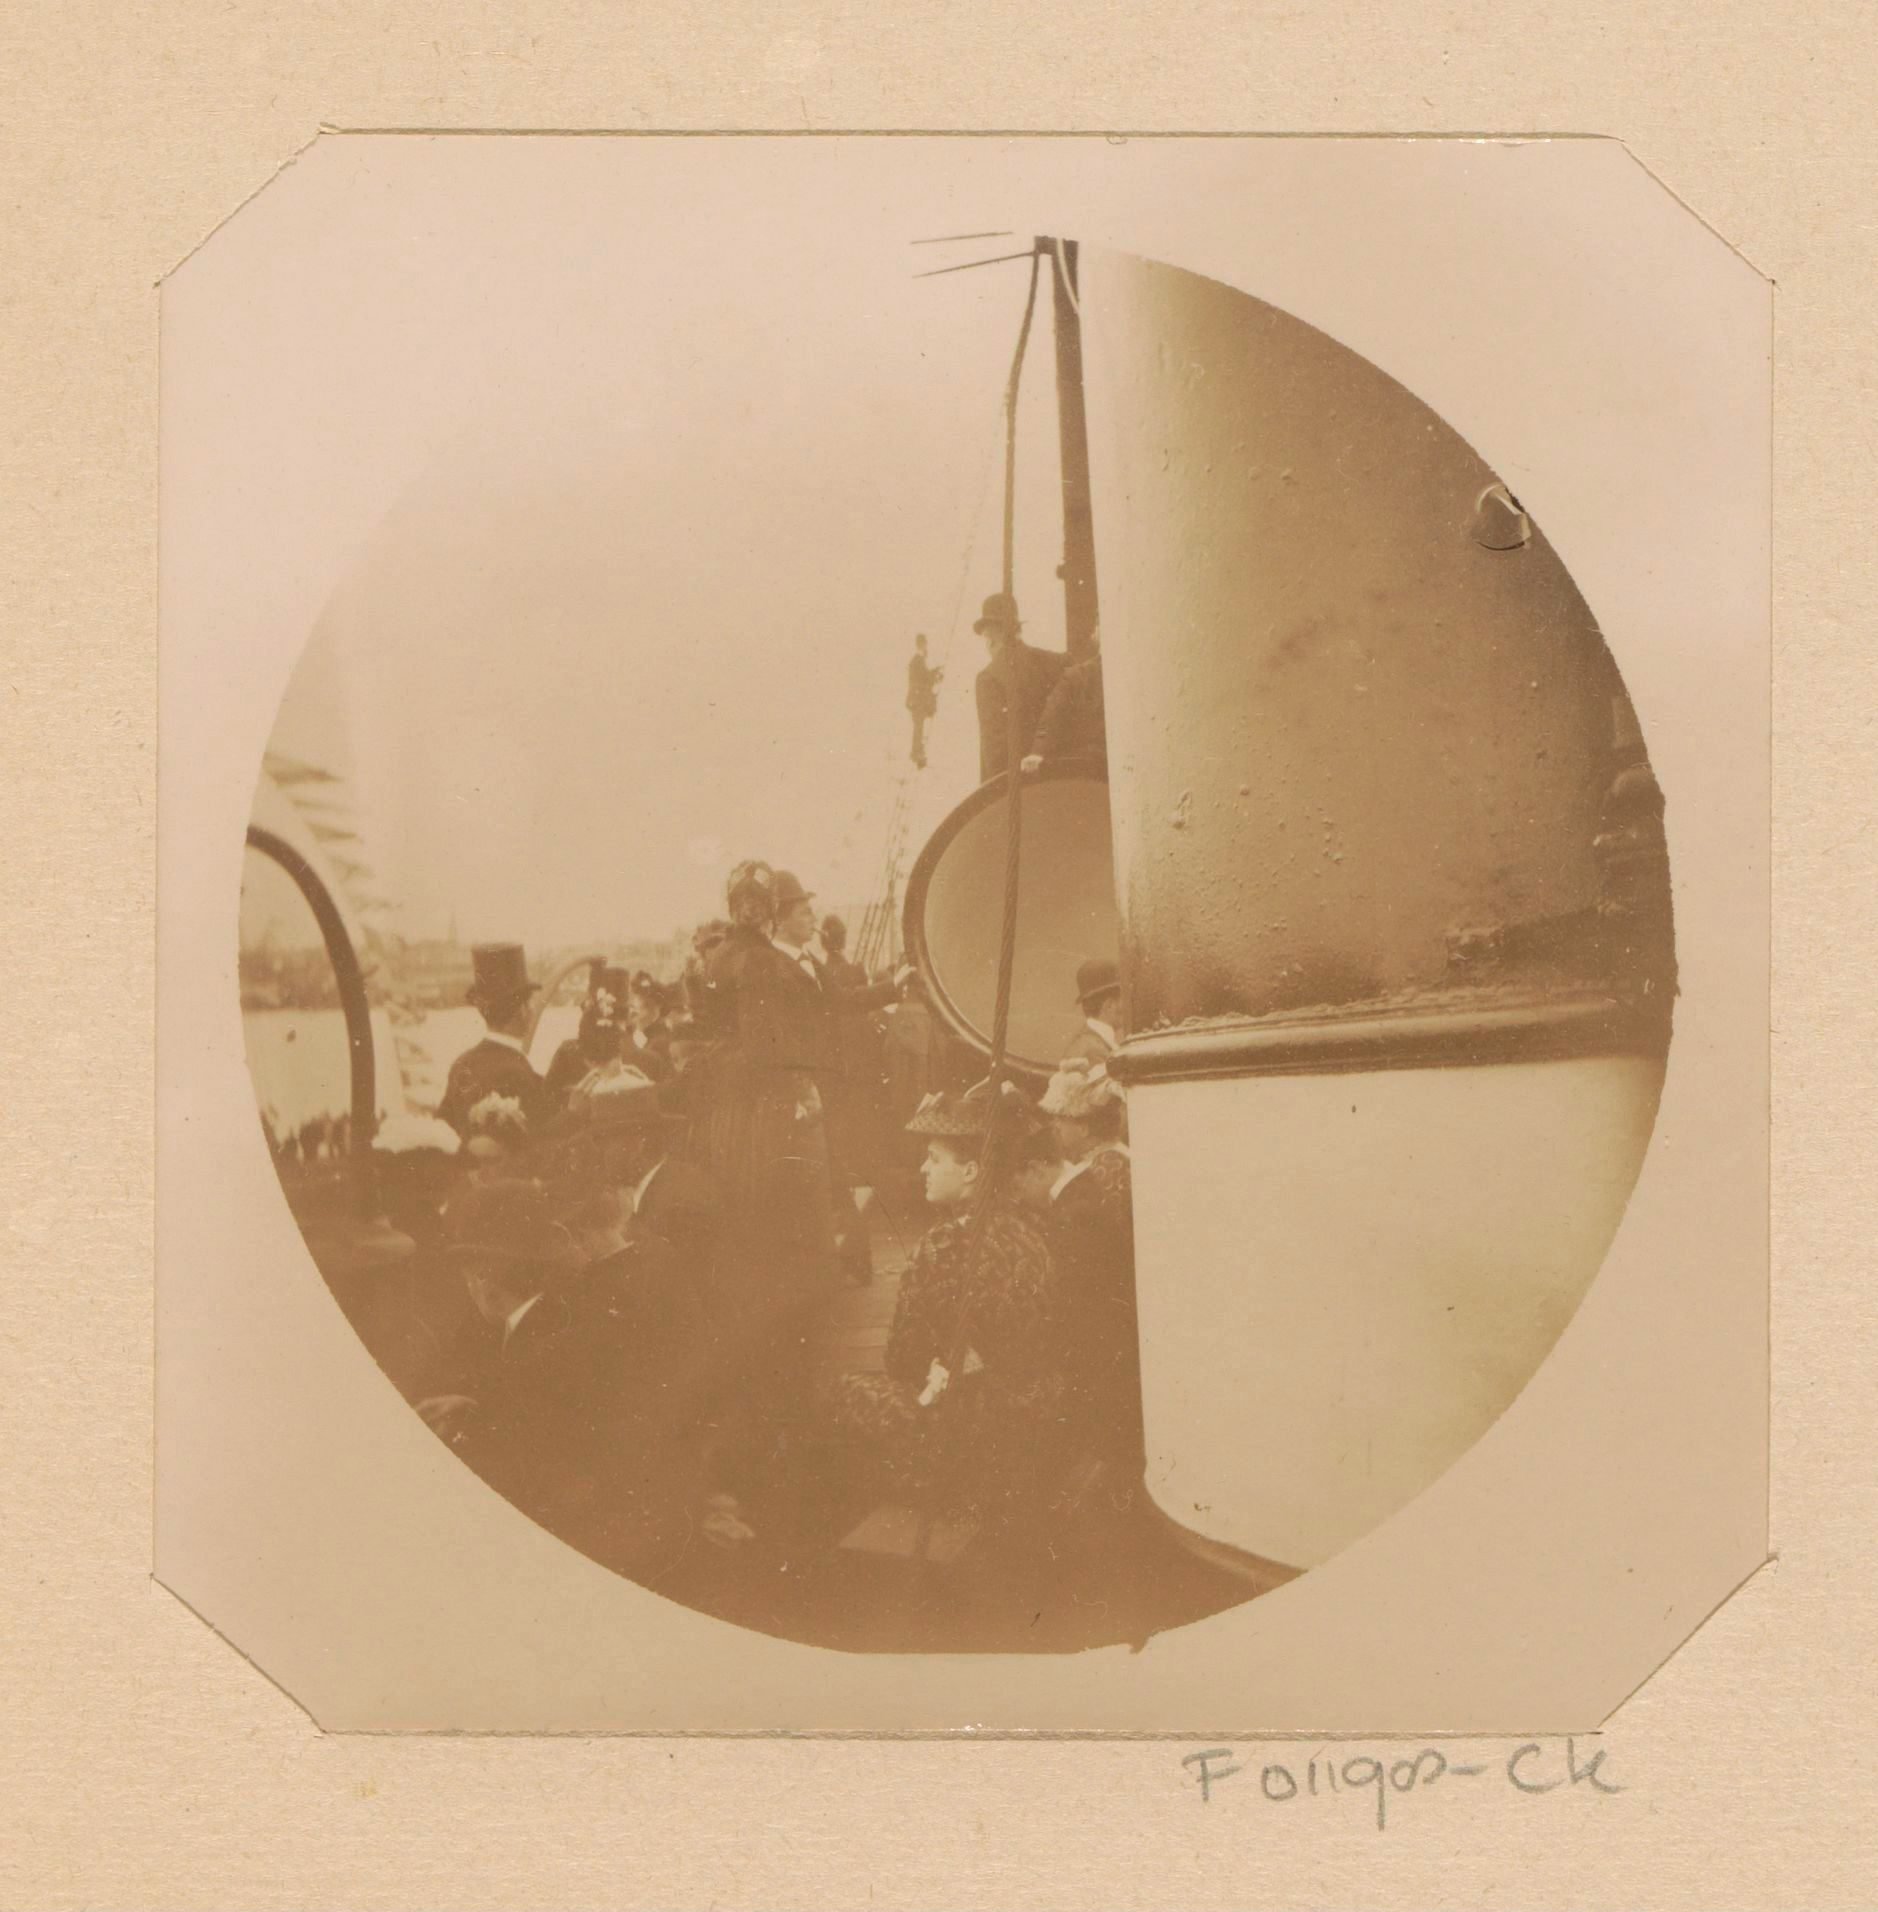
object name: album leaf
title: Keizersfeesten 1891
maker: johanna margaretha piek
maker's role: fotograaf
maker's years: 1870-1947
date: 1891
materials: paper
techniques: gelatin silver print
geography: amsterdam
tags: ships (in general), imperial celebrations 1891